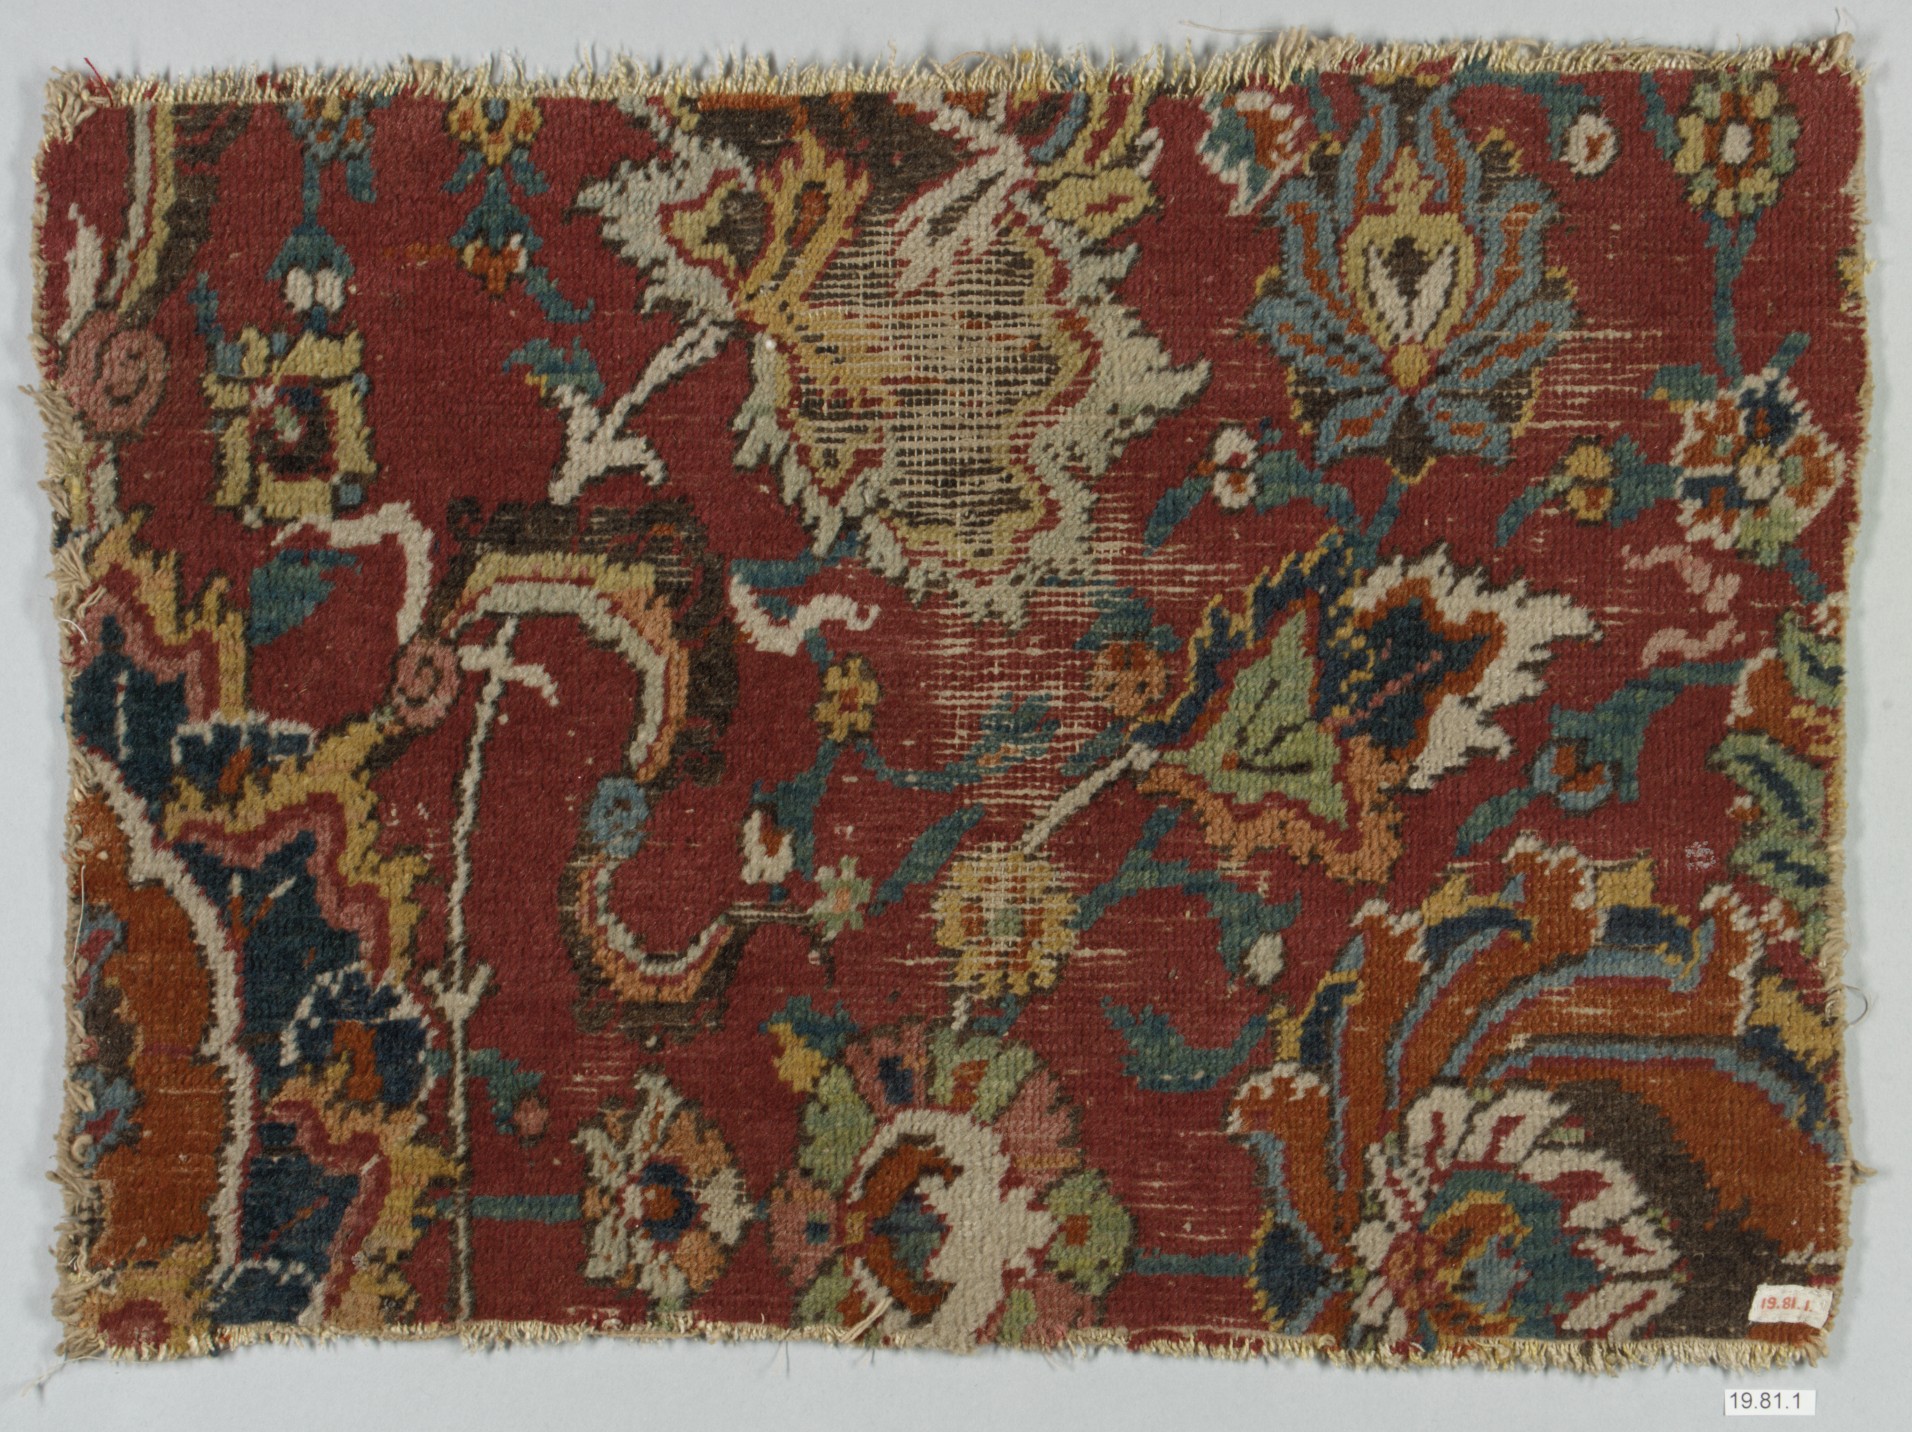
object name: carpet fragment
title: Fragment of a Floral Carpet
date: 1501-1600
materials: silk, wool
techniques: asymmetrically knotted pile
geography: iran